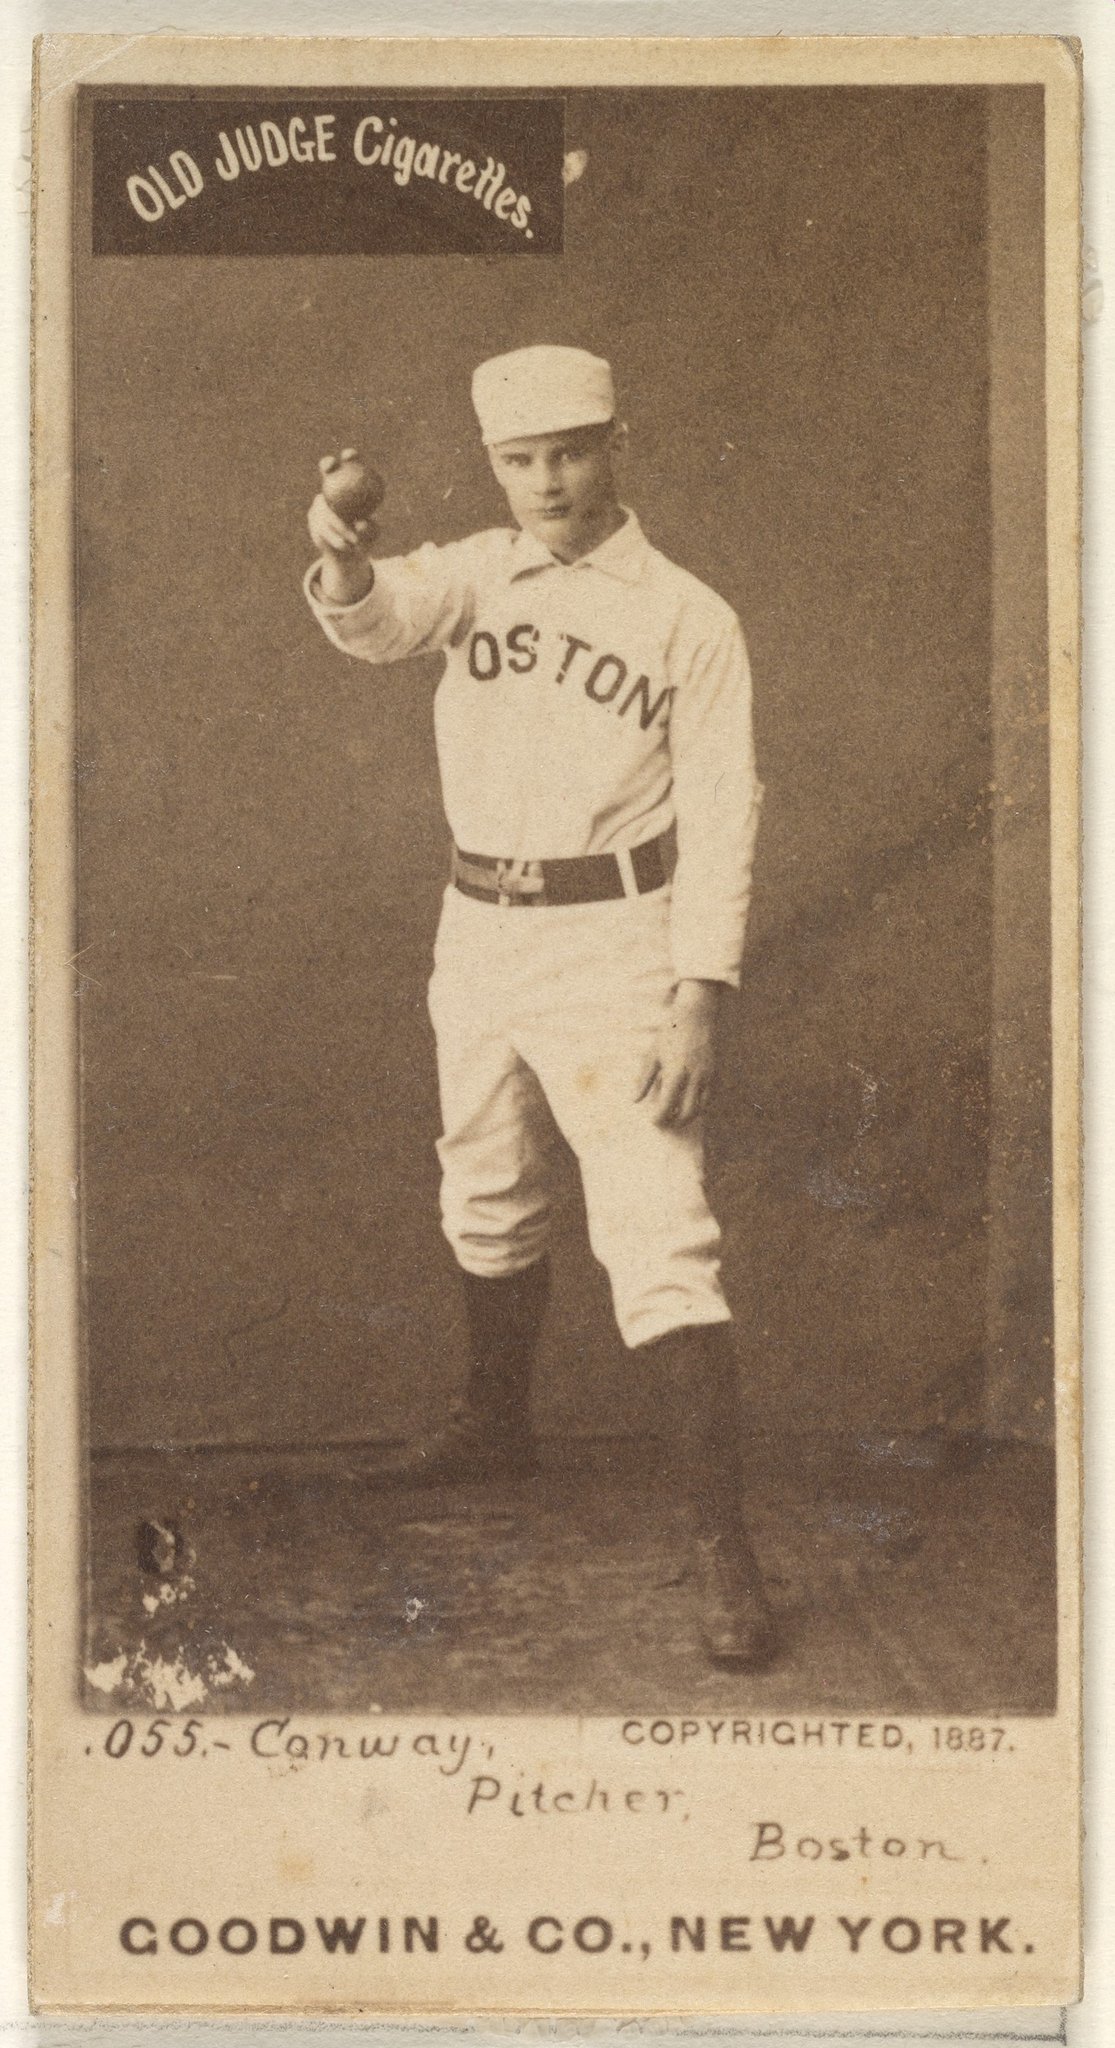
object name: baseball card, photograph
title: Conway, Pitcher, Boston, from the Old Judge series (N172) for Old Judge Cigarettes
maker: goodwin & company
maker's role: publisher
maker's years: 1850-1950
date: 1887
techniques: albumen silver print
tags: men,portraits,baseball,athletes